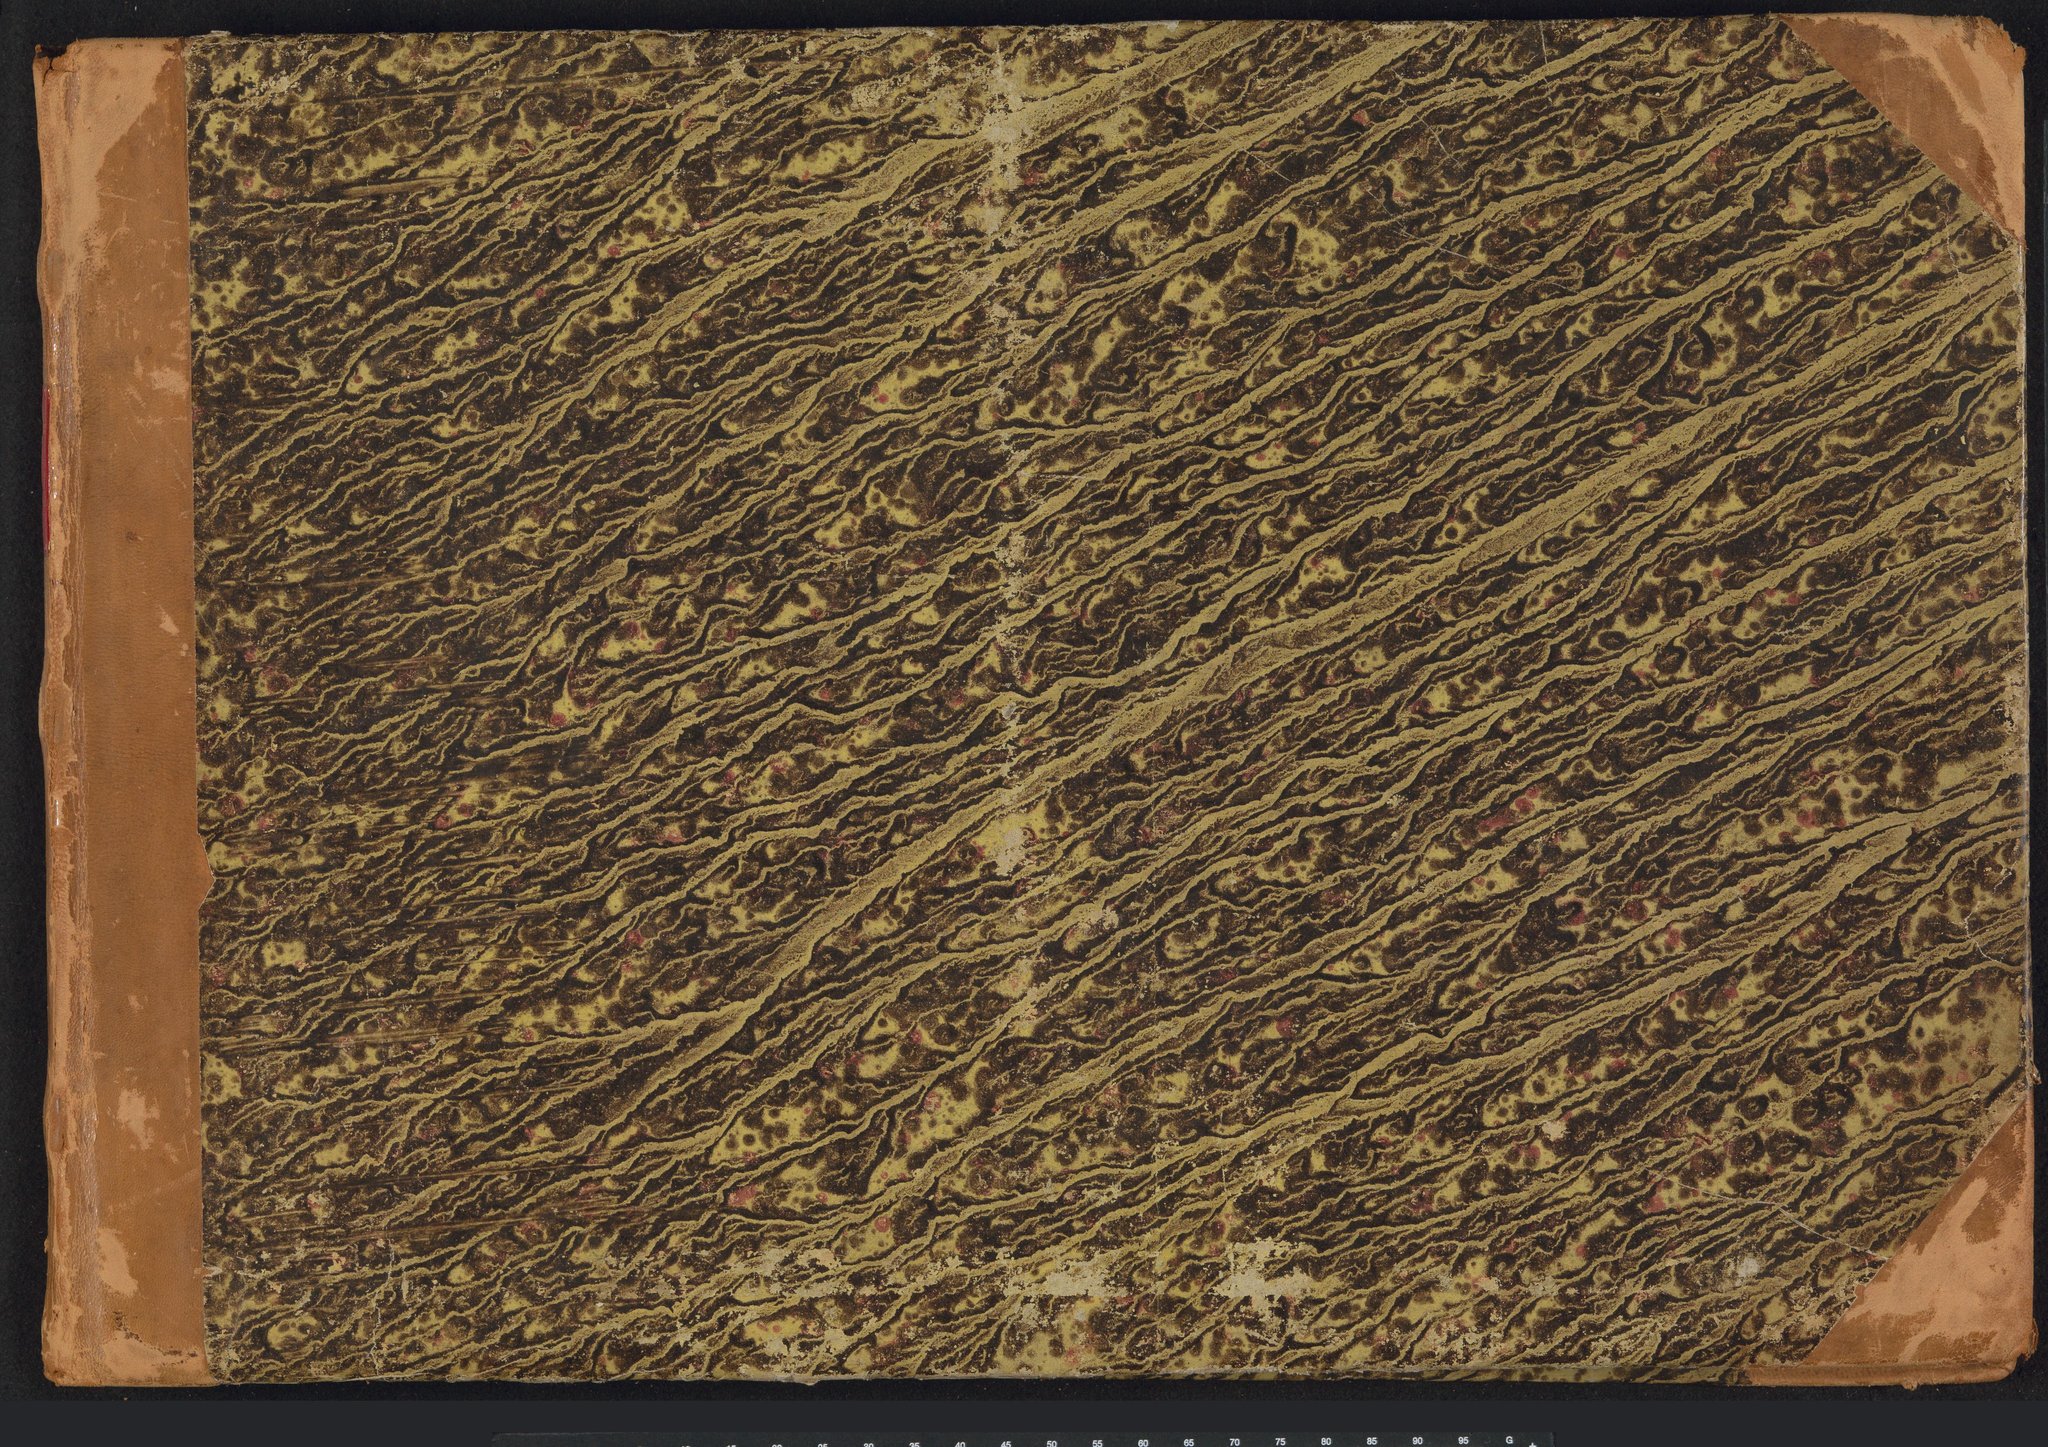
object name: prentrecueil, prentenalbum, prentalbum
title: Sigismundi Augusti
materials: cardboard, ink, leather, paper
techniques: bookbinding, etching, marbling, pen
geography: italy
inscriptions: number: ‘301’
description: Simon Schijnvoet heeft in 1709 aan het album het Schijnvoet-nummer 4, liber nummer 7 toegekend.